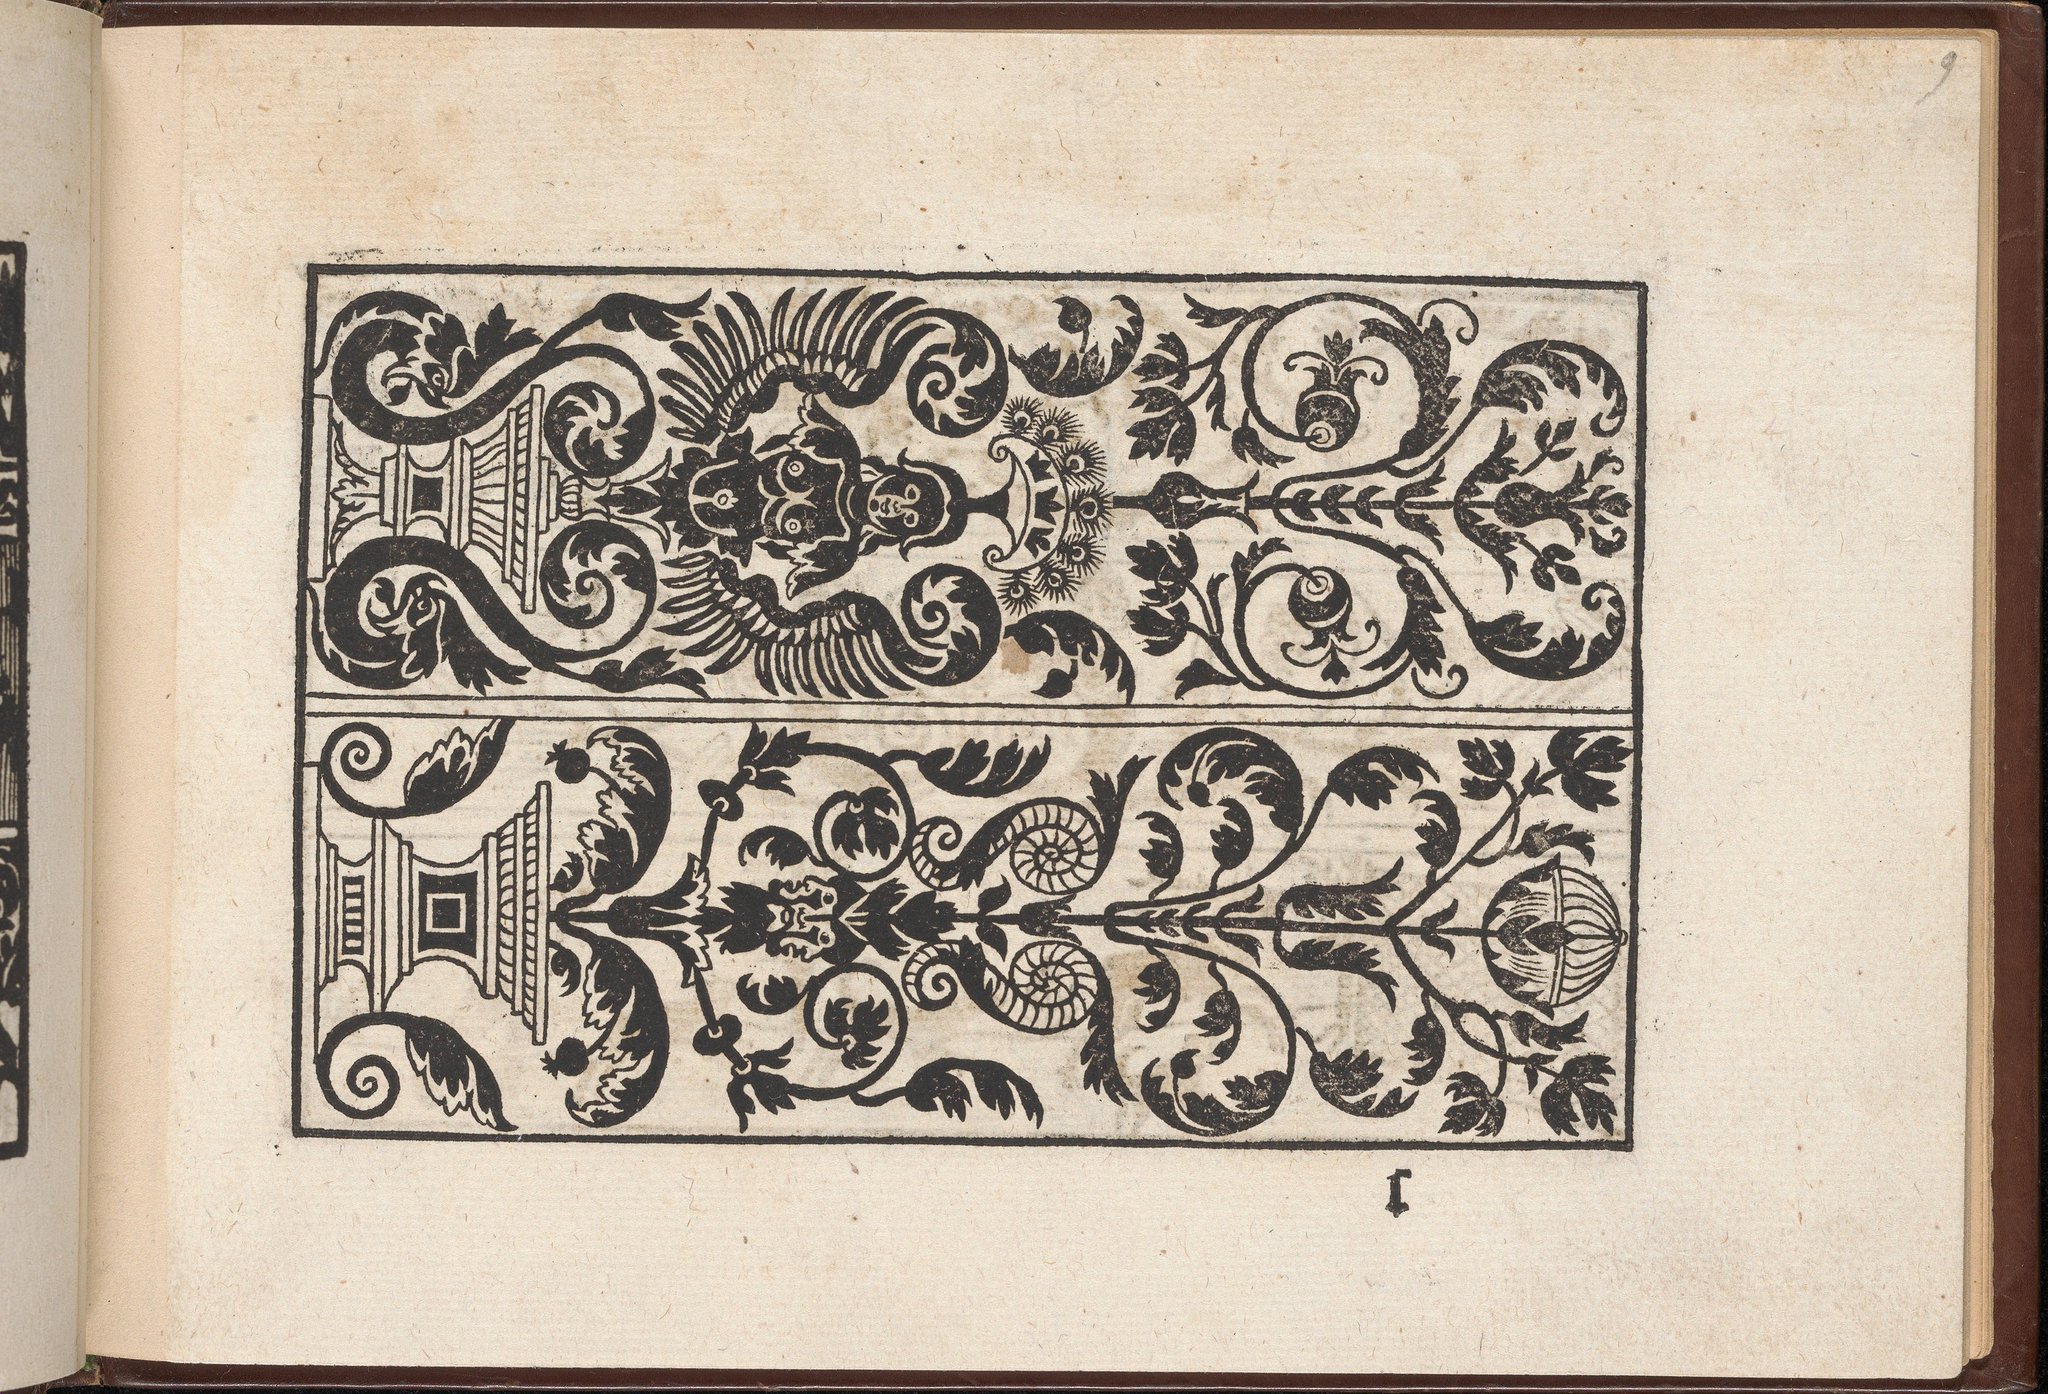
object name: book print ornament architecture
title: Page from Eyn Newe kunstlich moetdelboech alle kunst (Page 9r)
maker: peter quentel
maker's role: publisher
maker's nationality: german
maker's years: 1500-1550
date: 1532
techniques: woodcut